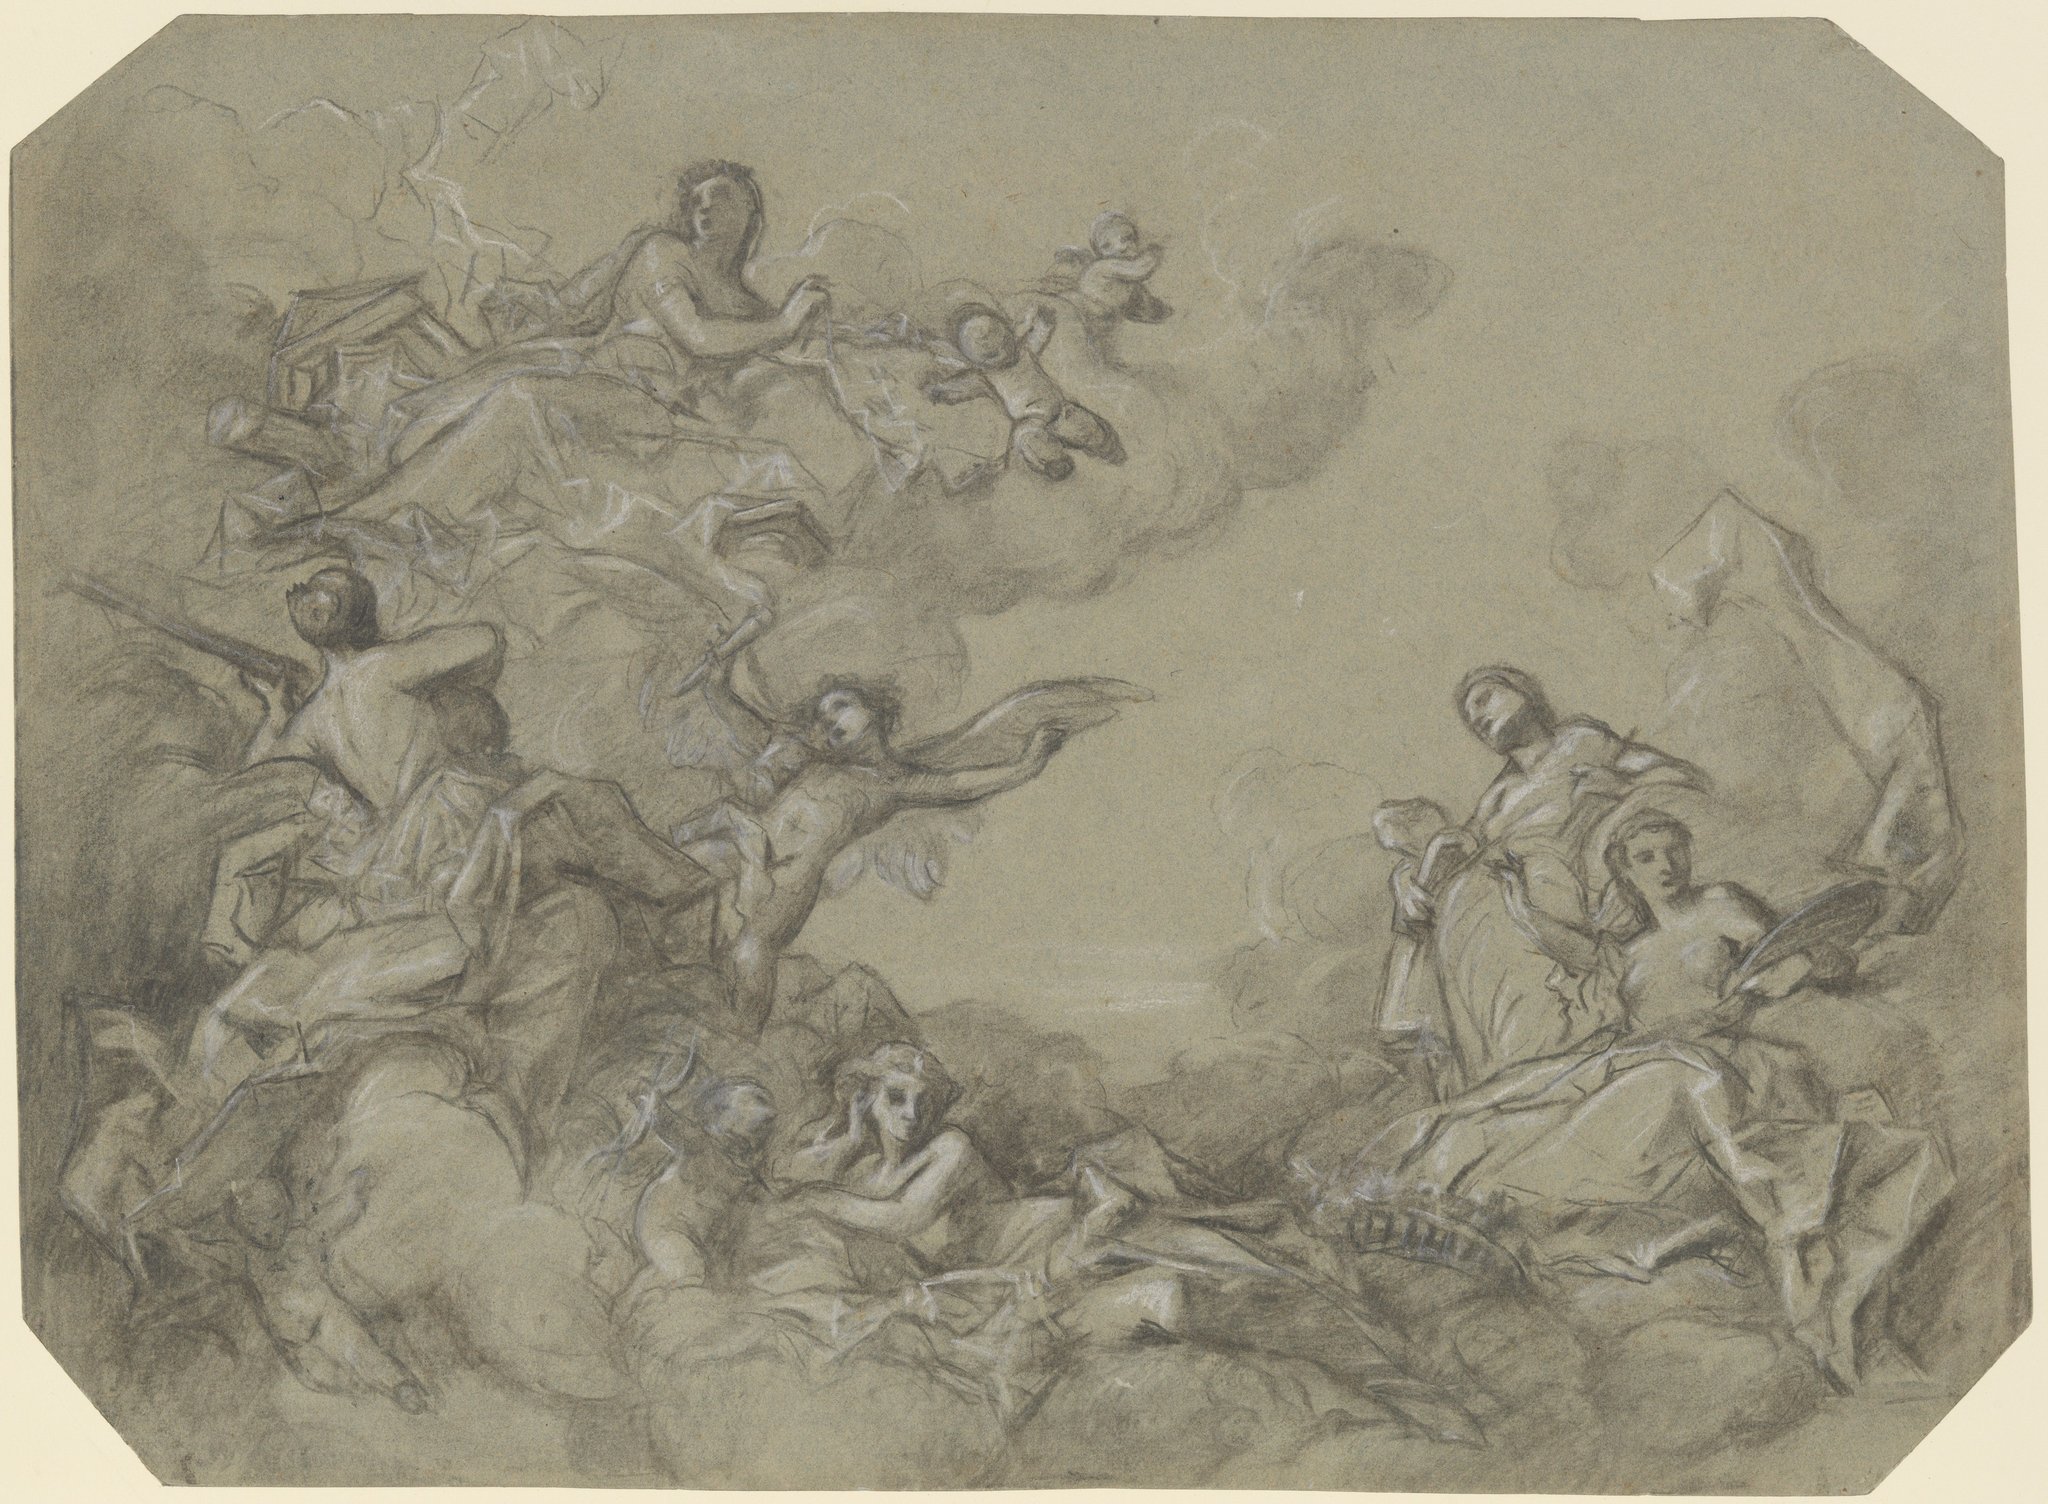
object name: drawing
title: Study for a ceiling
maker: charles joshua chaplin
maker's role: artist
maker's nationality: french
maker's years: 1825-1891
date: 1840-1891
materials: chalk, paper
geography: france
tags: men,women